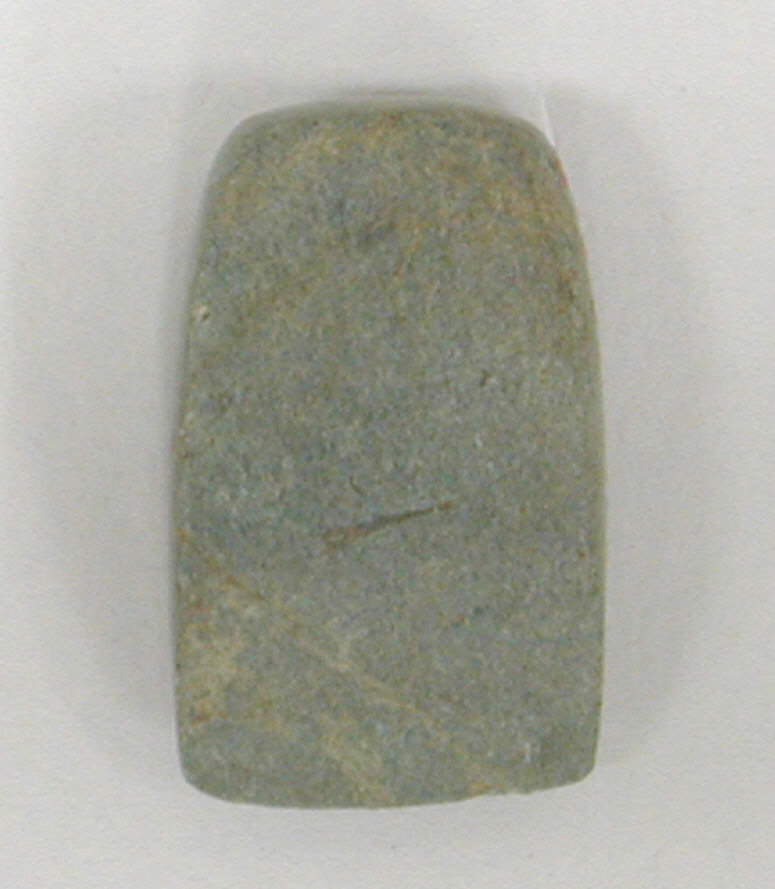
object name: celt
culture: maya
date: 1501-1600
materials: stone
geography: guatemala